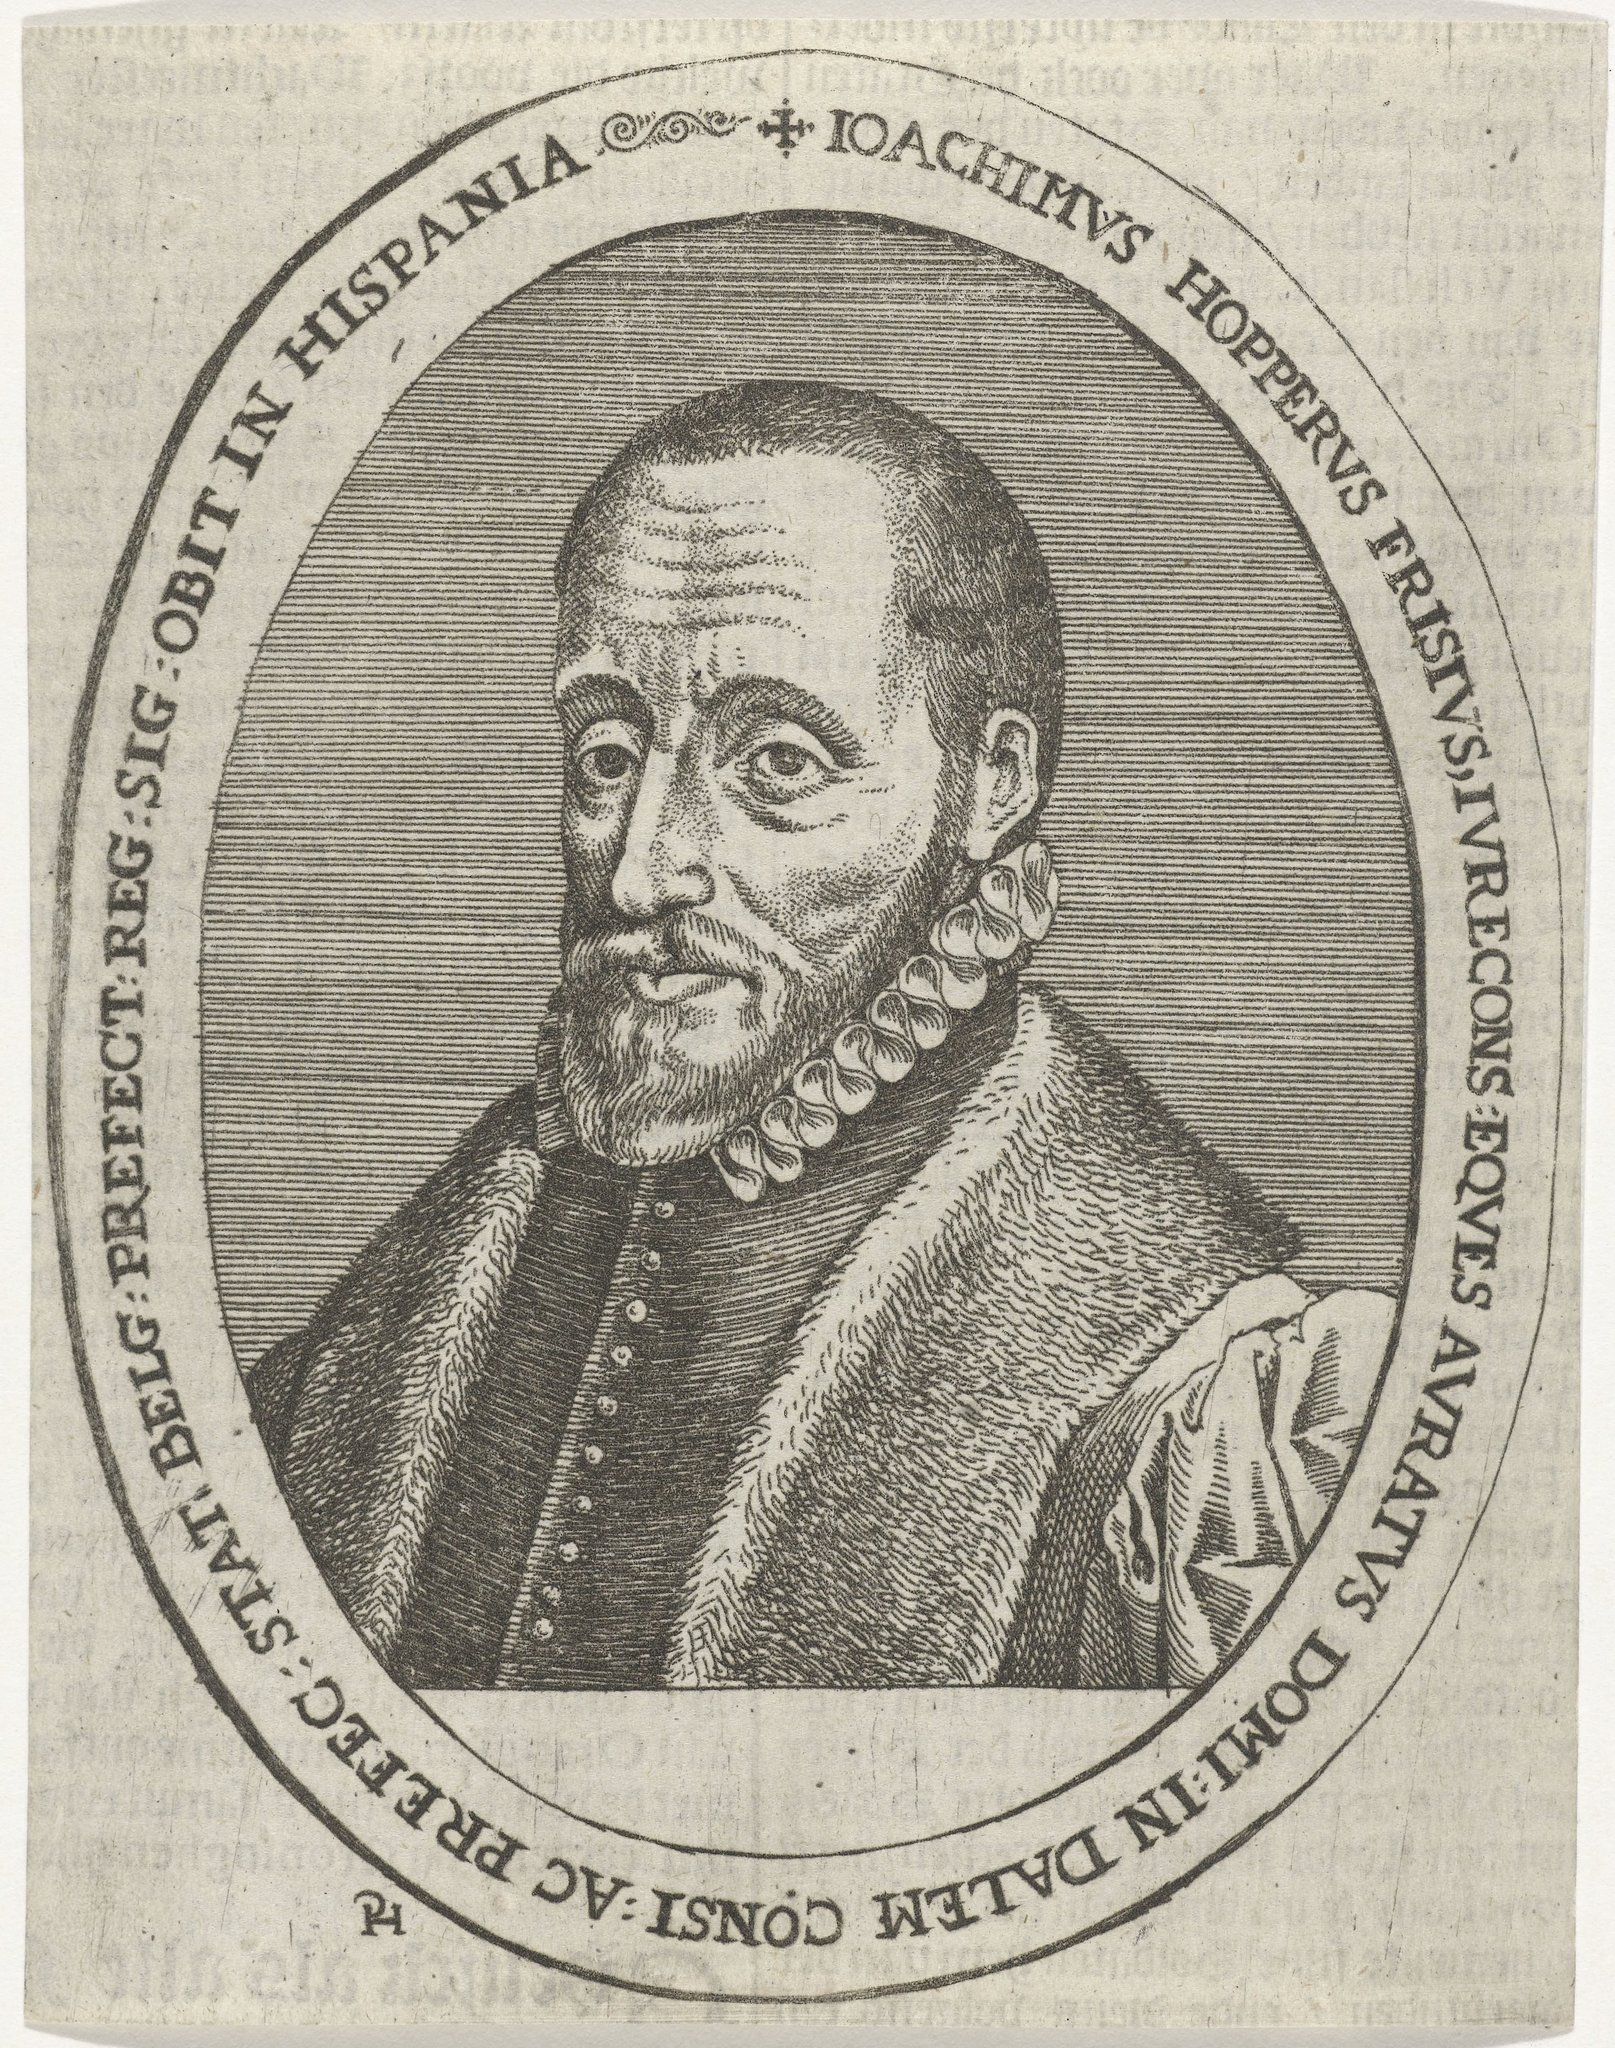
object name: book illustration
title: Ioachimvs Hopperus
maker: pieter feddes van harlingen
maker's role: painter, print maker, publisher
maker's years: 1586-1623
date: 1611-1623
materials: paper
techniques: etching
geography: friesland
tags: sneek, jurist, joachim hopperus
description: Busteportret van de Friese jurist Joachim Hopperus, afgebeeld in ovale omlijsting met randschrift.